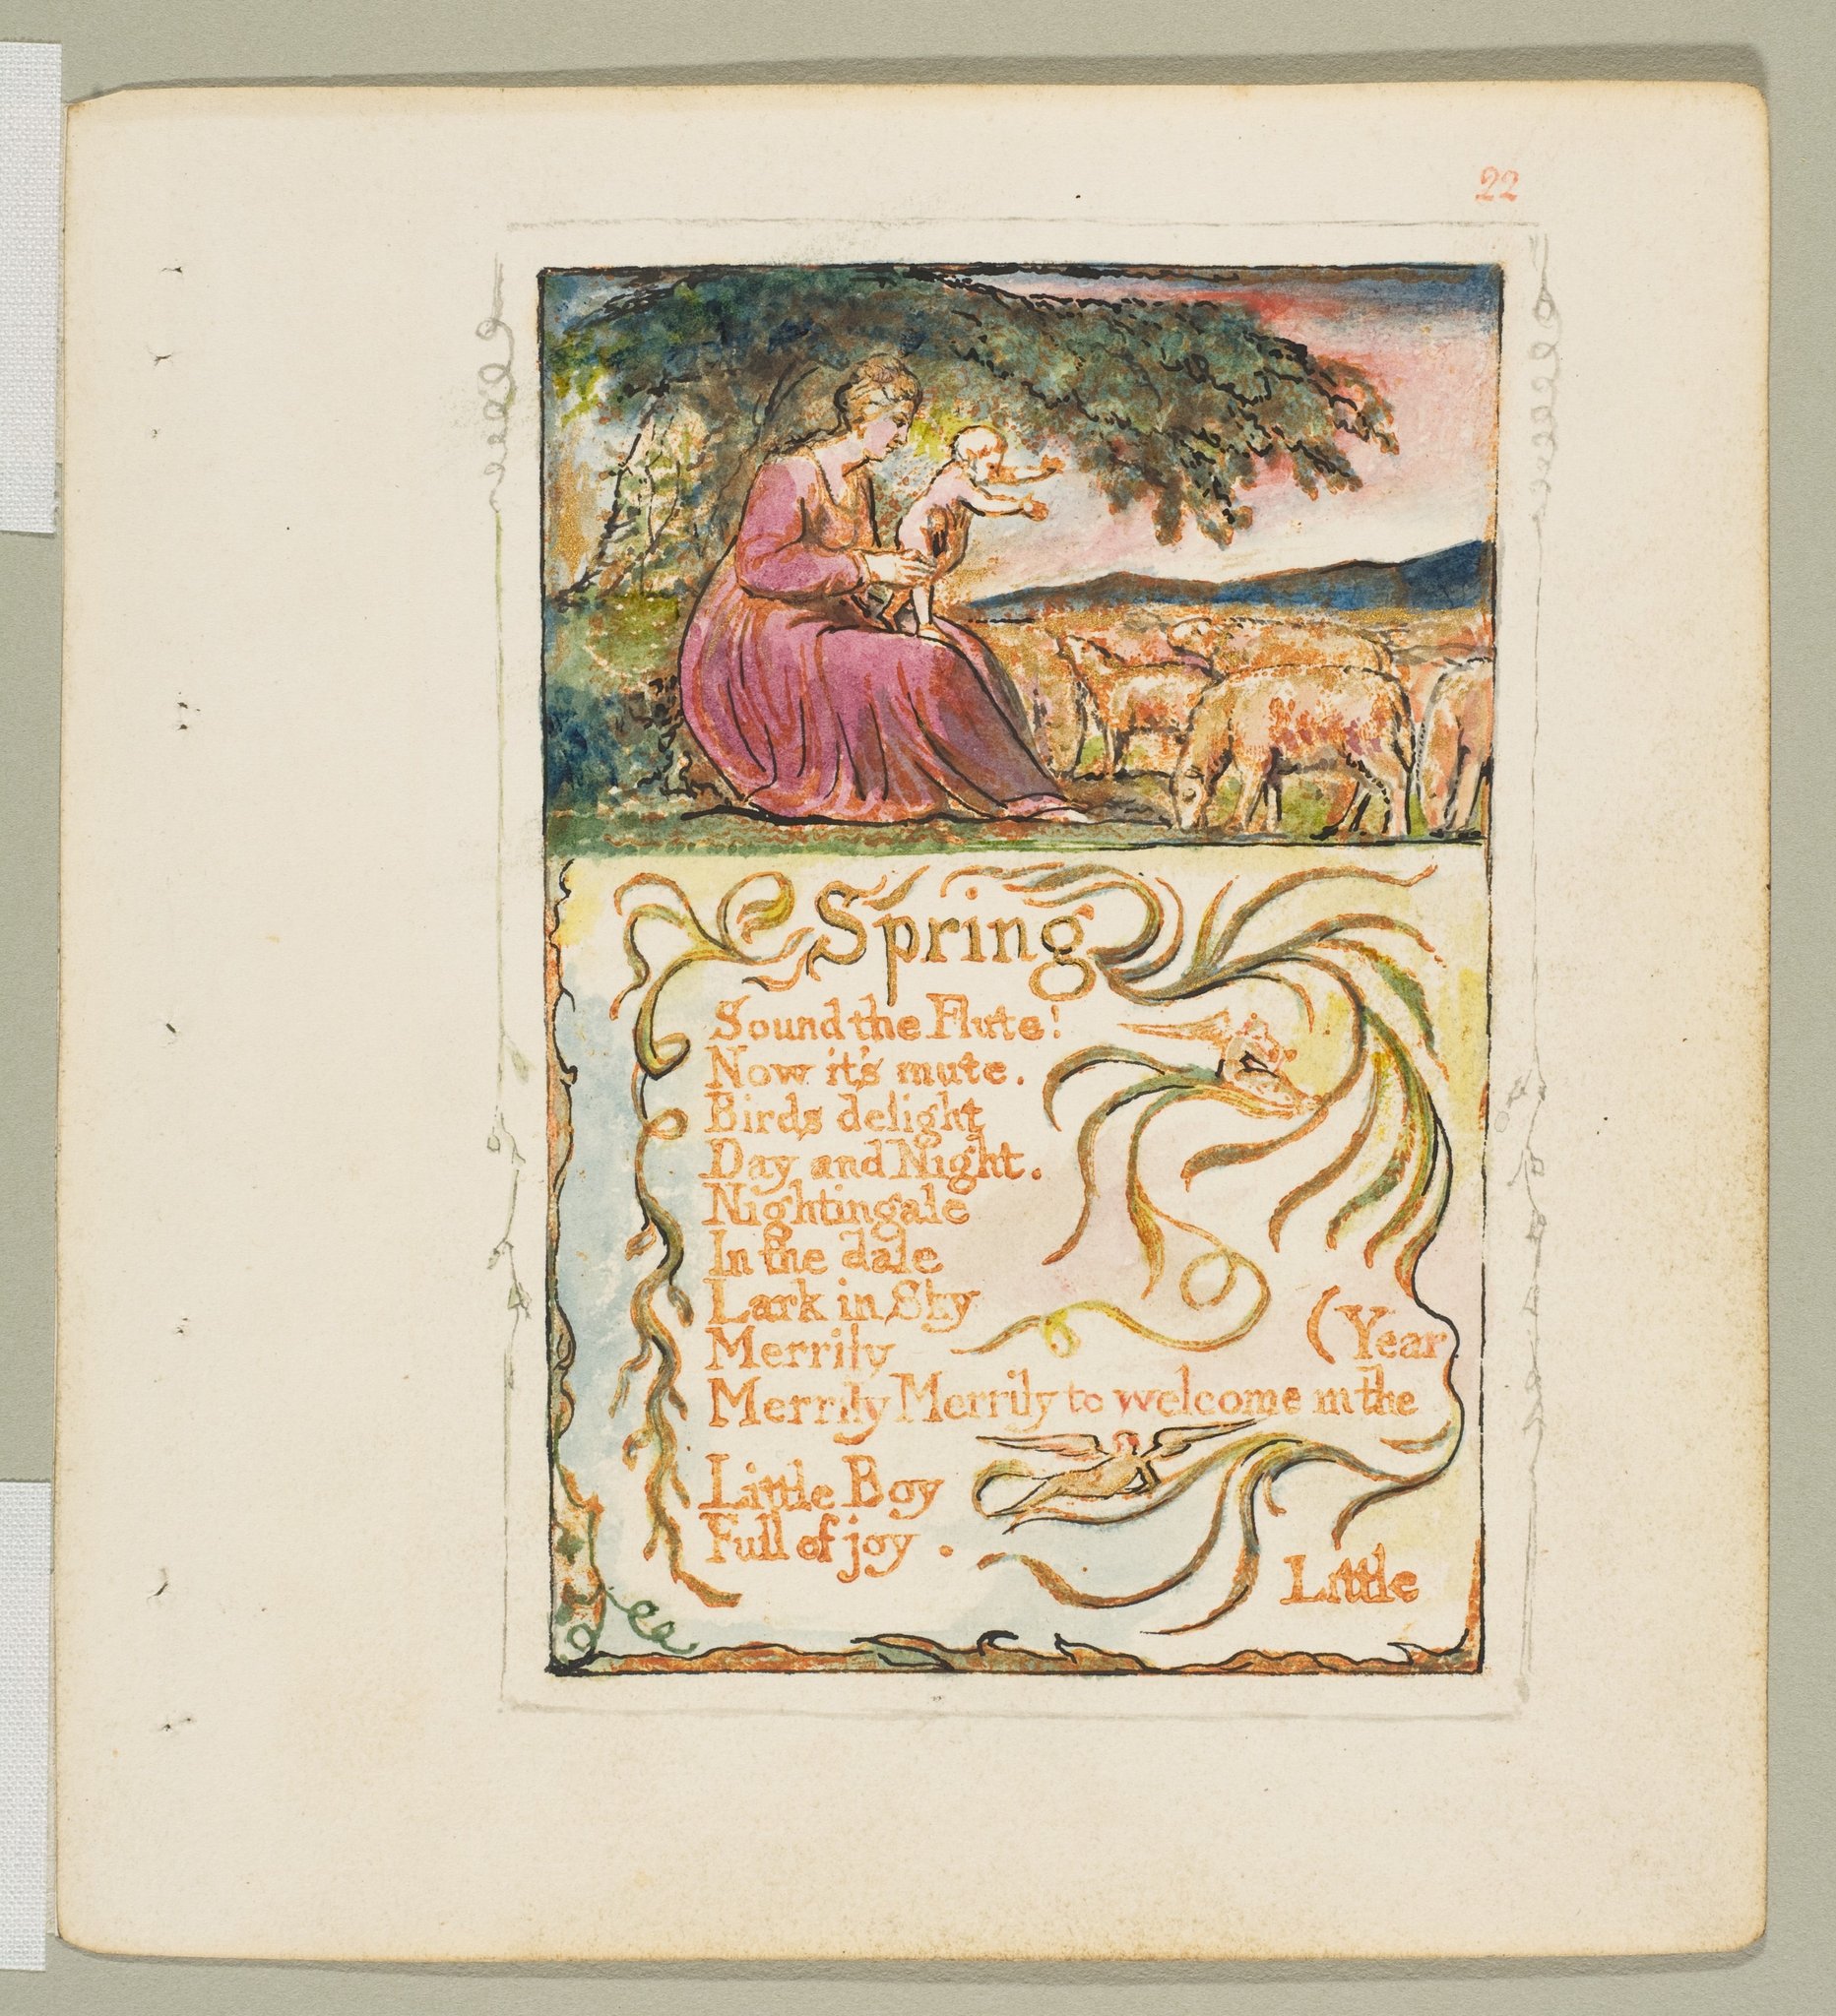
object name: print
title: Songs of Innocence: Spring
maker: william blake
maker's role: artist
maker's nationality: british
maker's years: 1757-1827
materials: gold, ink, shell, watercolor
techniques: etching, hand coloring, printing, relief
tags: poetry,children,women,sheep